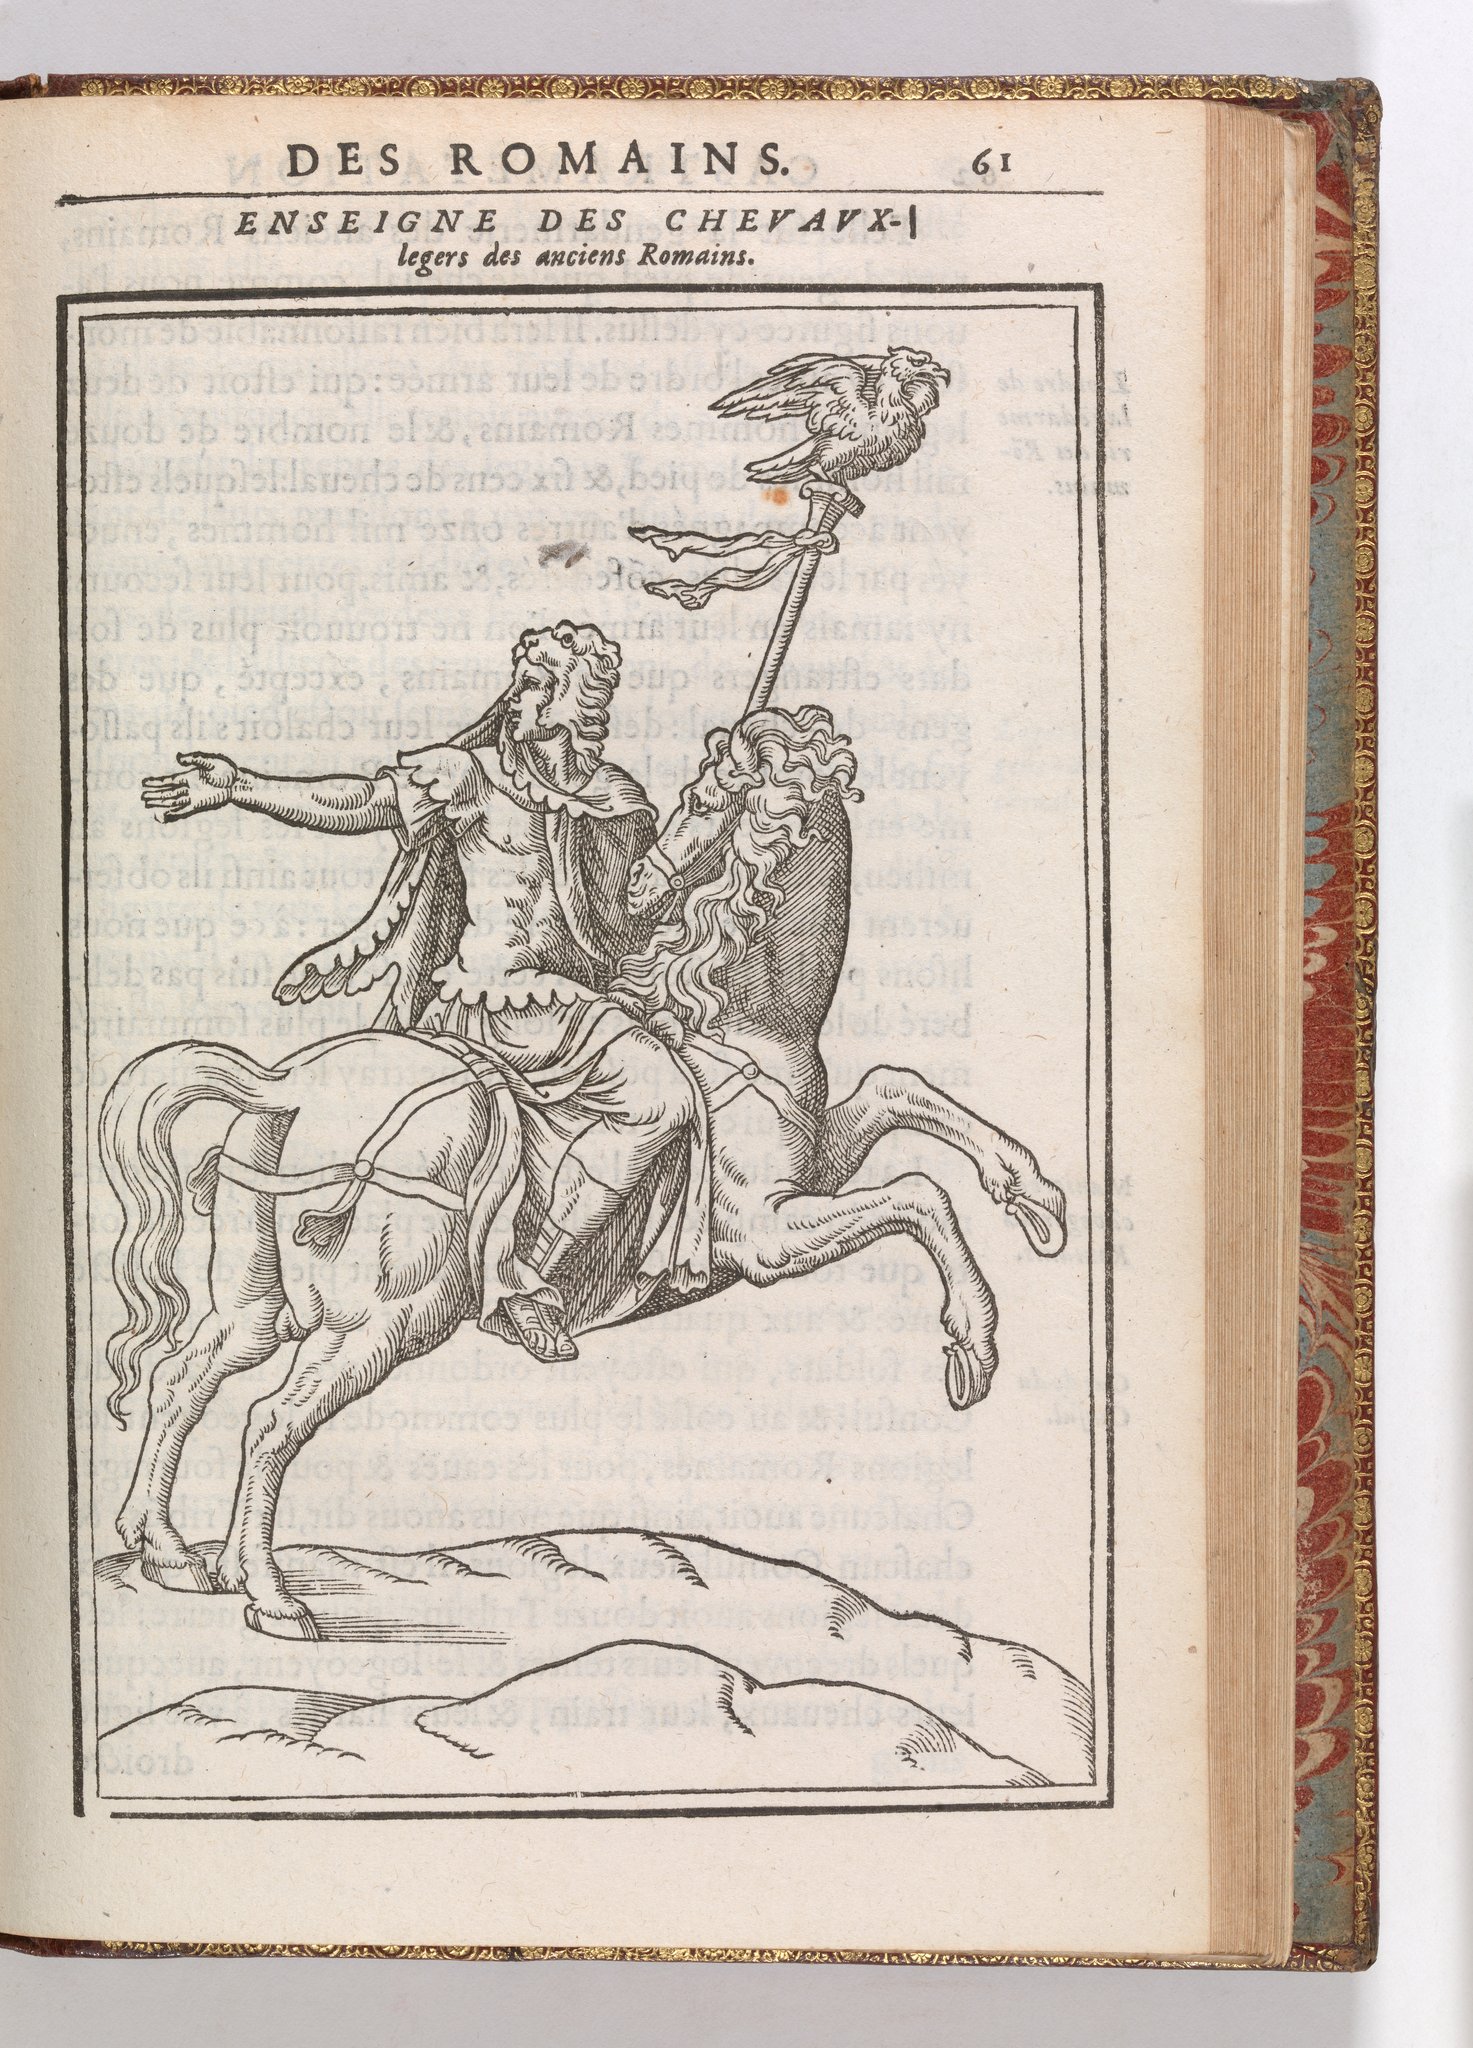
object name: book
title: Discours de la Religion des Anciens Romains... Discours sur la Castramentation et Discipline Militaire des Anciens Romains...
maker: guglielmo du choul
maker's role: author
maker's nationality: french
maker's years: 16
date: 1581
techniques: woodcut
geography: france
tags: eagles,men,horses